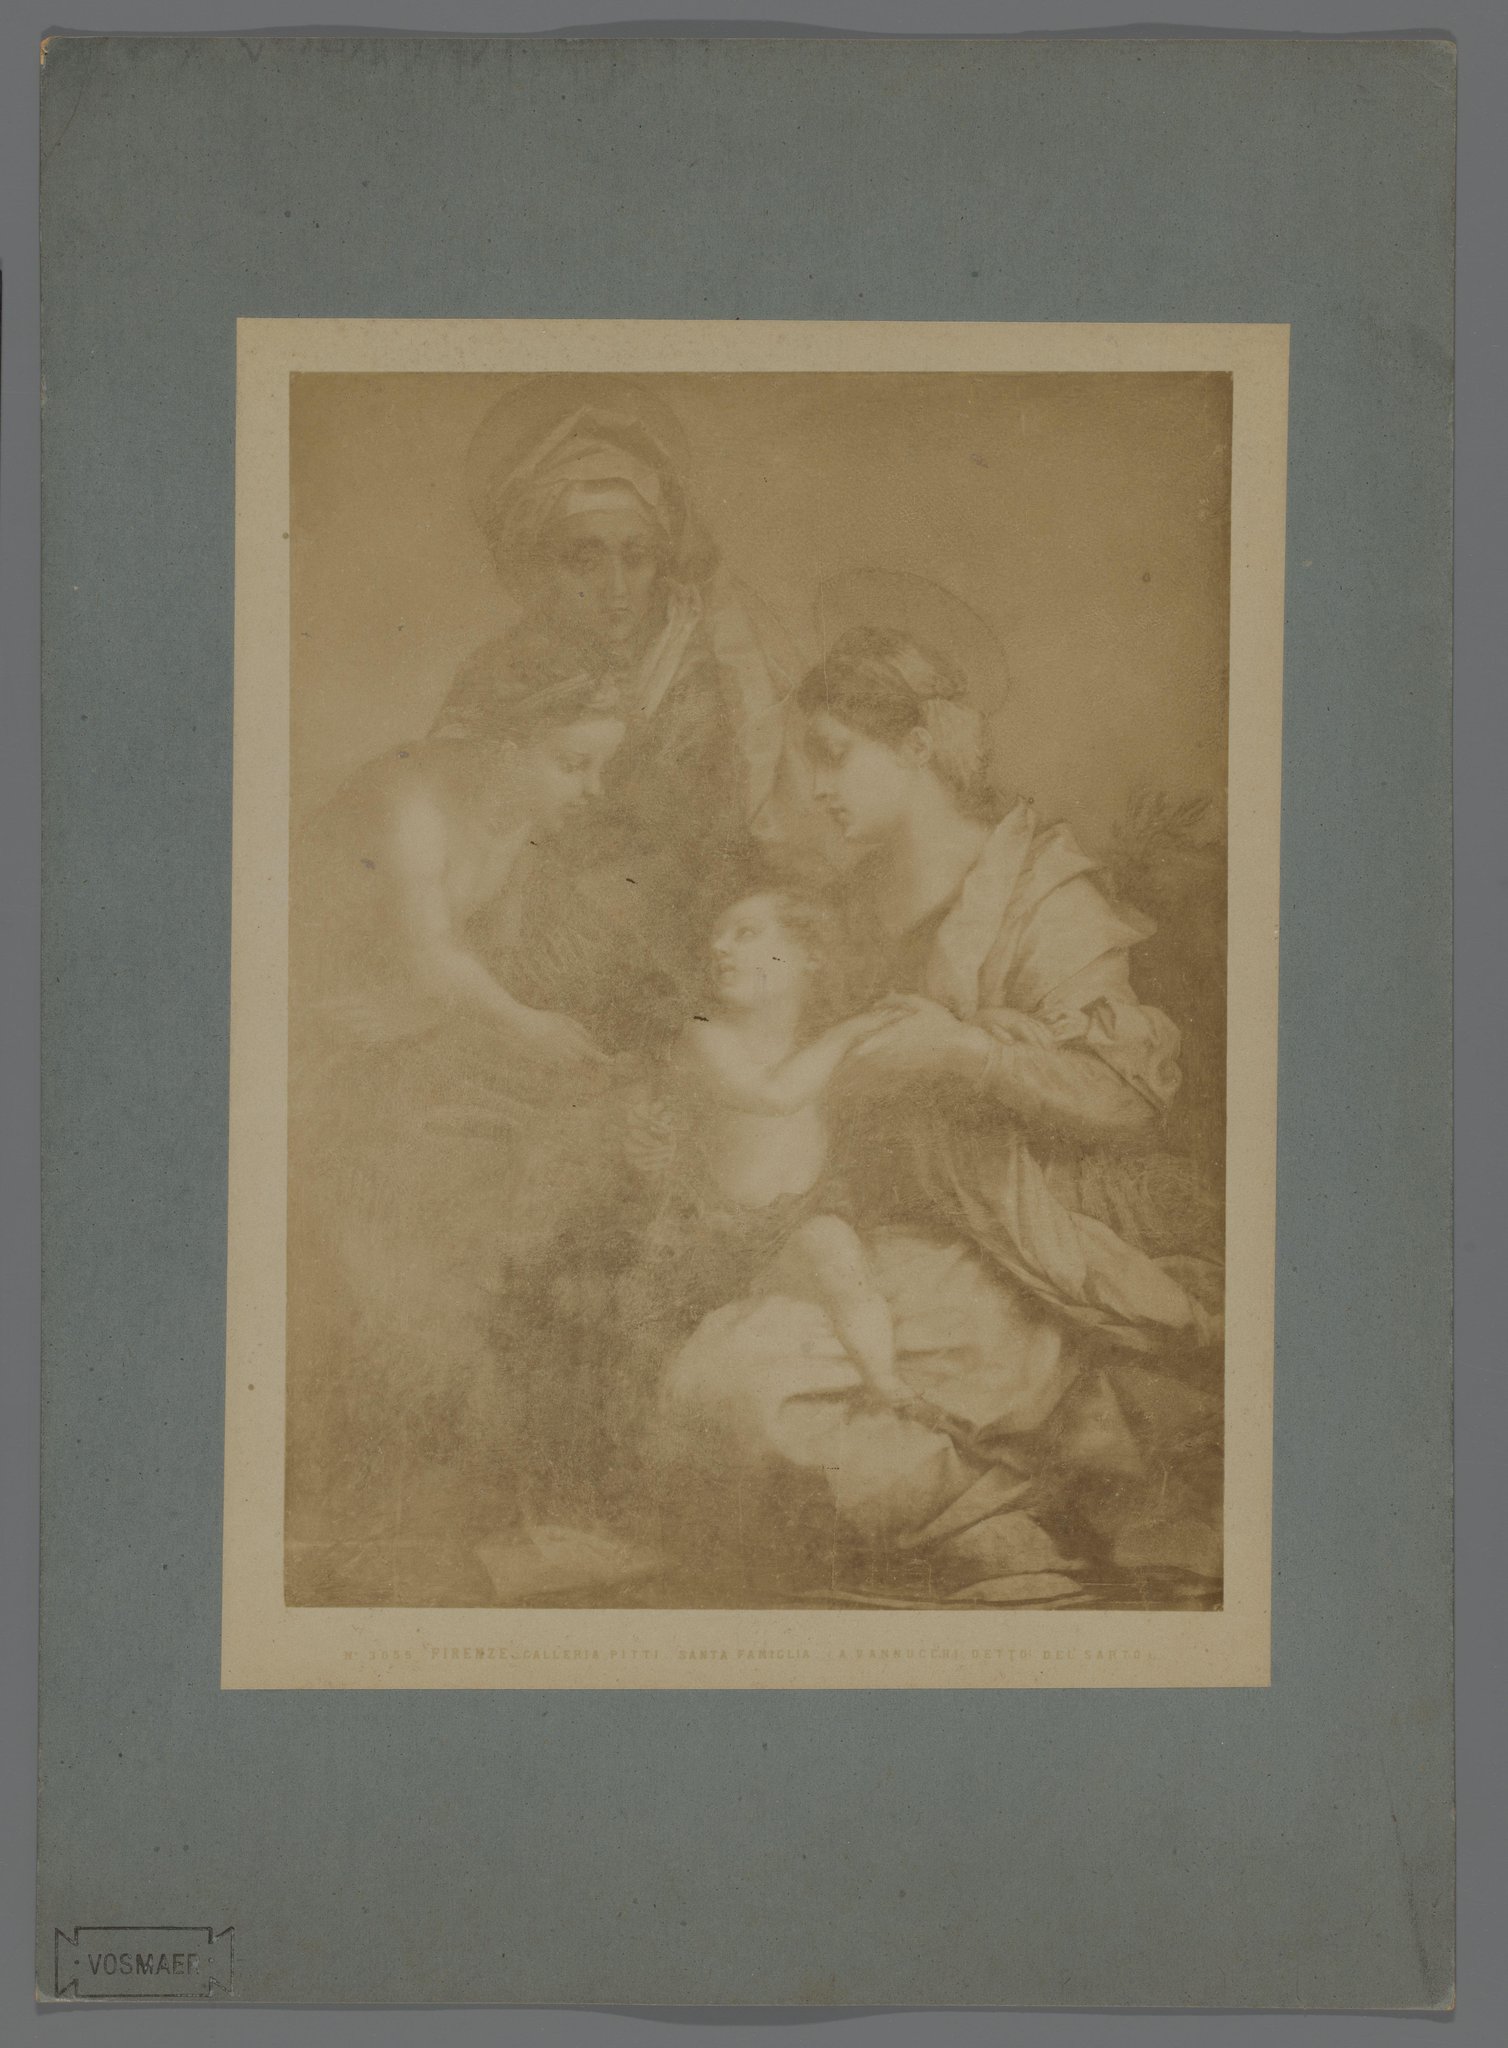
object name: photograph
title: Firenze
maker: andrea del sarto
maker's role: draughtsman, painter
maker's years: 1486-1531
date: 1857-1900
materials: cardboard, paper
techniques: albumen print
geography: florence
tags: picture, painting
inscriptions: number: ‘No. 3055.’, collector's mark: ‘VOSMAER’